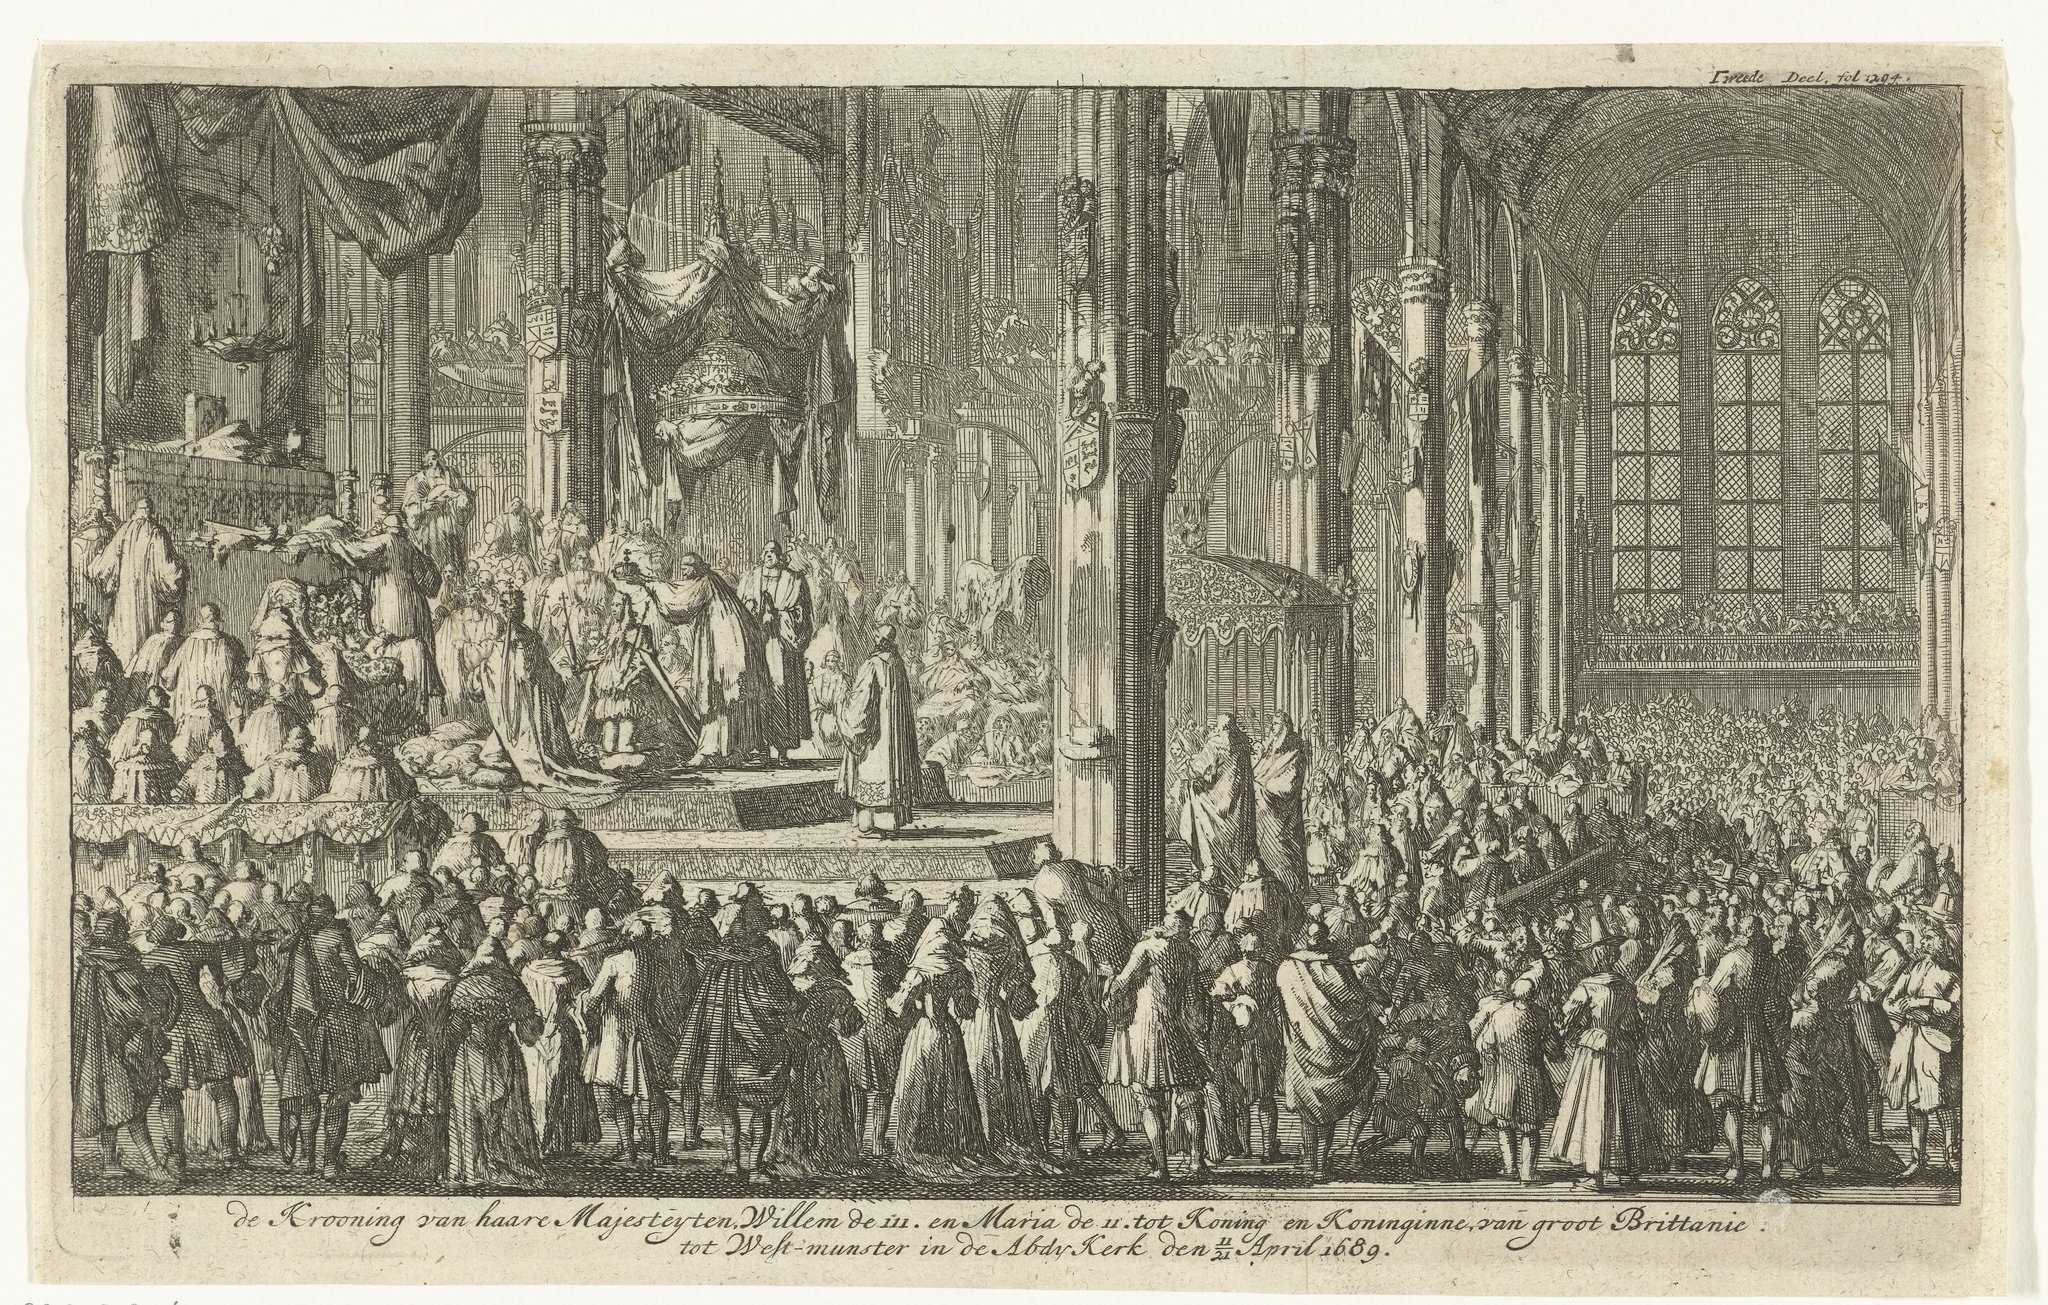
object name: print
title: de Krooning van haare Majesteyten, Willem de III. en Maria de II. tot Koning en Koninginne, van groot Brittanie: tot West-munster in de Abdy Kerk den 11/21 April 1689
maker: Anonymous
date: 1689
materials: paper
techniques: etching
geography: northern netherlands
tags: the hague, william iii (prince of orange and king of england, scotland, and ireland), london, maria ii stuart (koningin van engeland, schotland en ierland), during the coronation, westminster abbey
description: Kroning van prins Willem III en prinses Maria II Stuart tot koning en koningin van Engeland in de Westminster Abbey, 21 april 1689. Gemerkt rechtsboven: Tweede Deel, fol: 294.